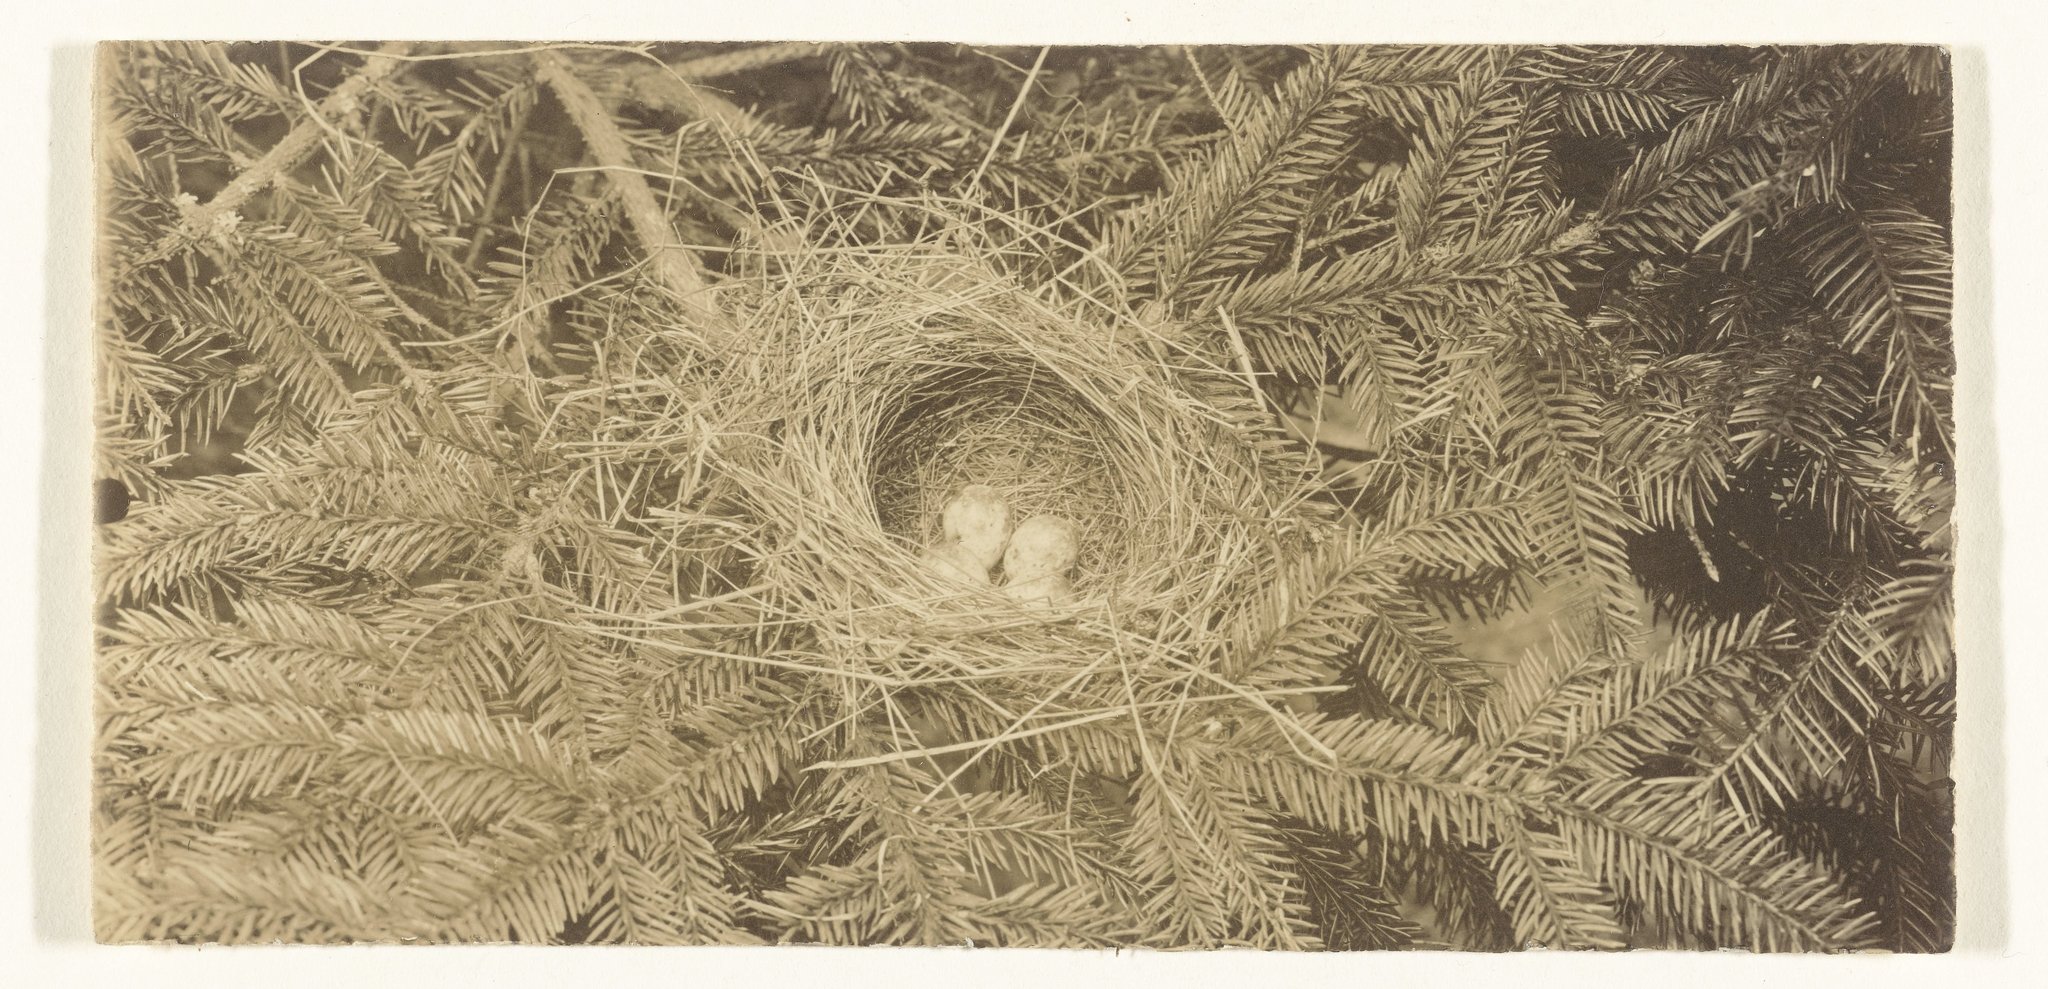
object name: photograph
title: Nest met eieren in boom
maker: richard tepe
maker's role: fotograaf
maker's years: 1864-1952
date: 1900-1930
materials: paper, photographic support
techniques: gelatin silver print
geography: netherlands